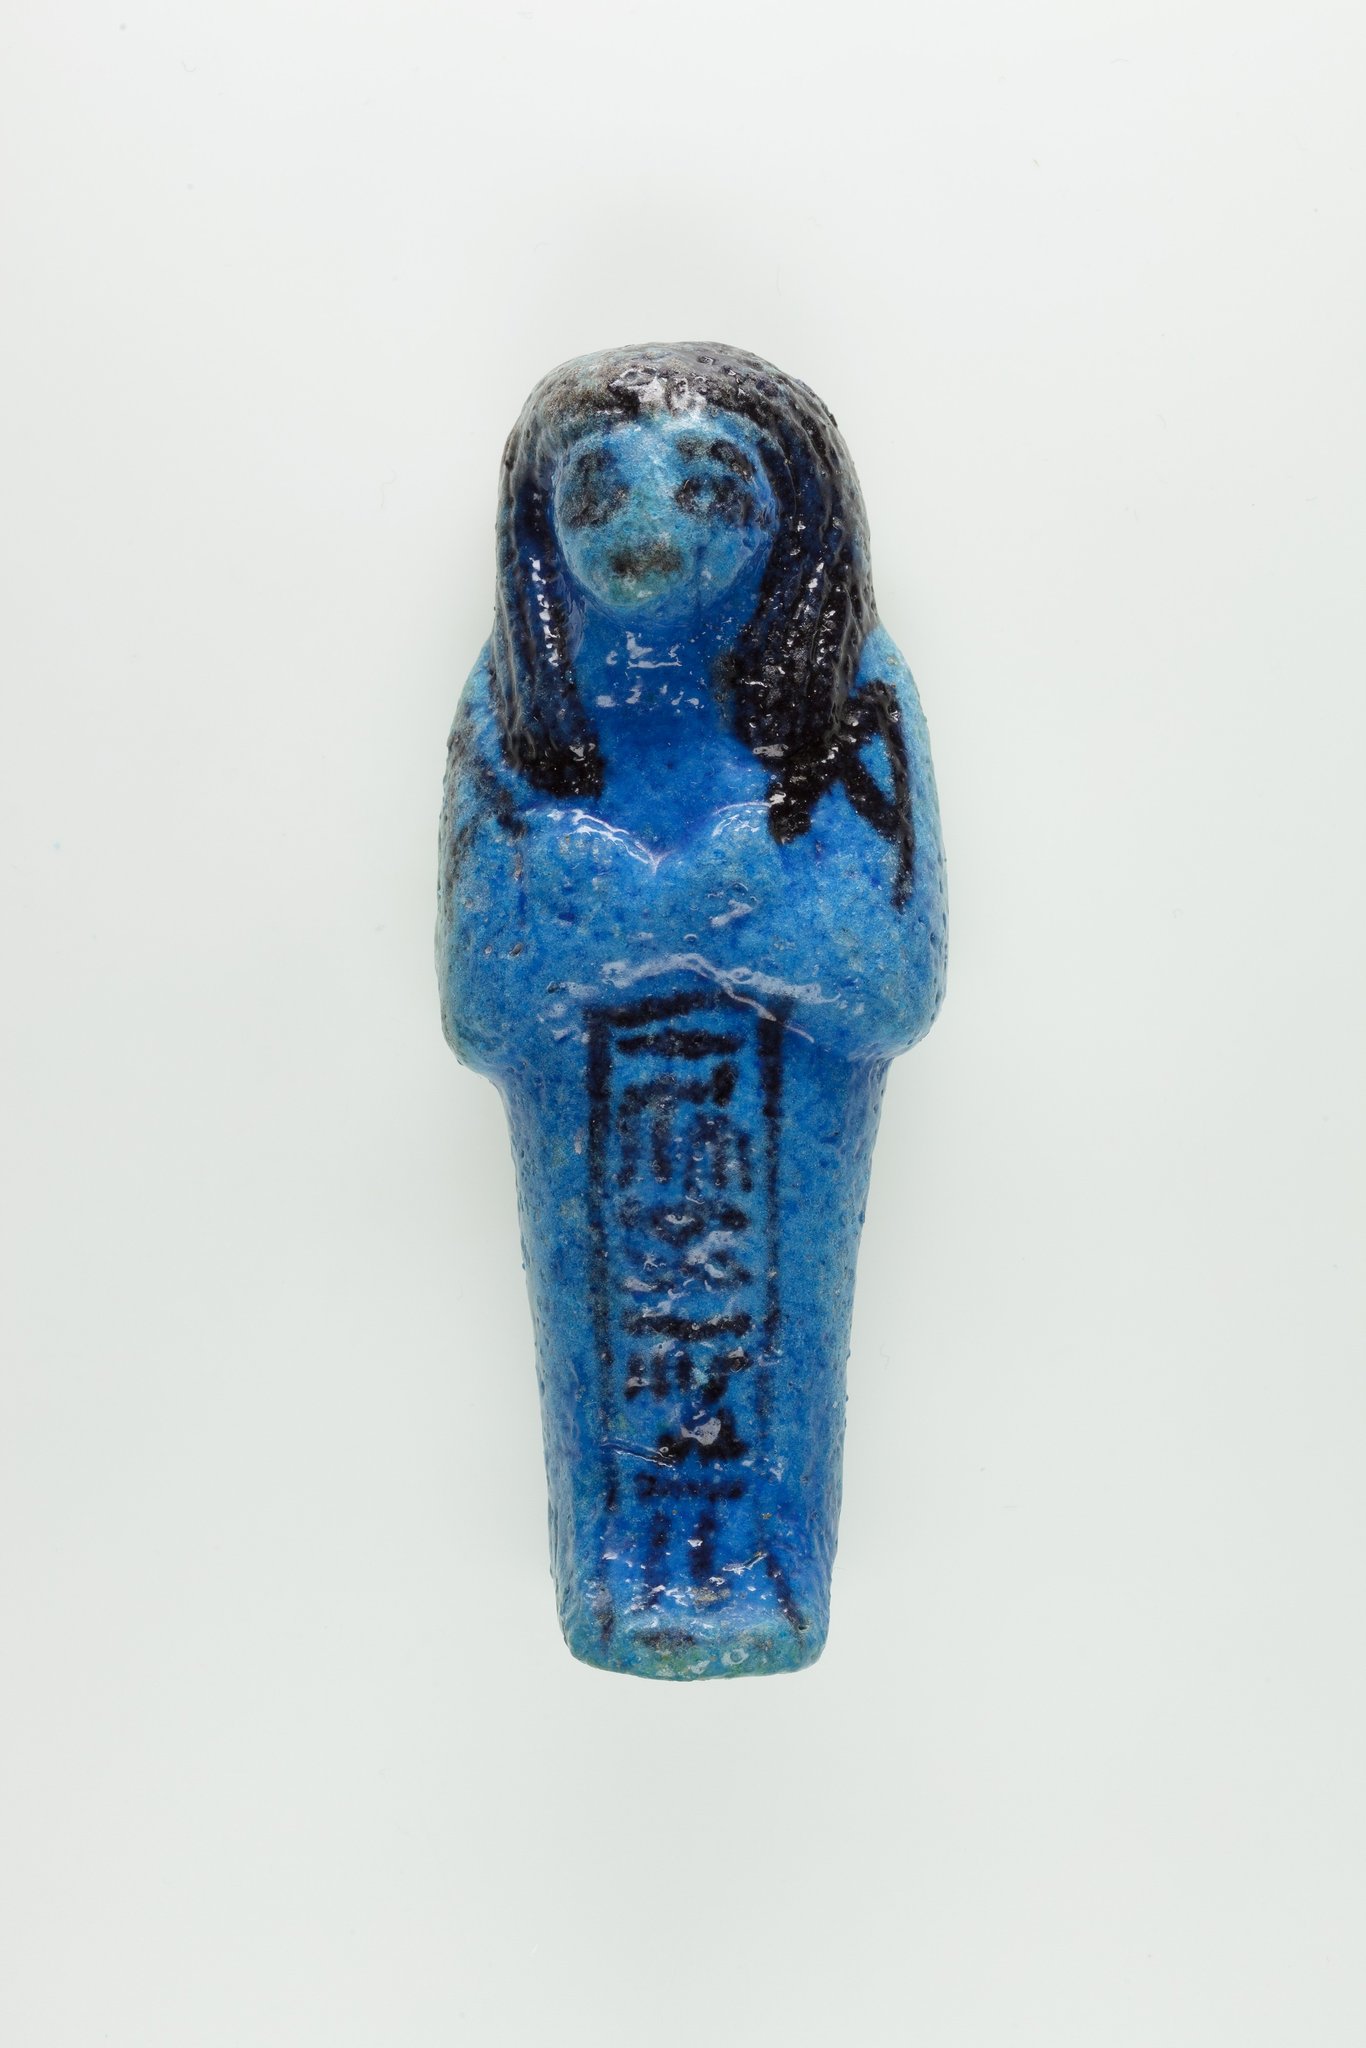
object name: shabti, worker, nauny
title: Worker Shabti of Nauny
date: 1050 BCE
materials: faience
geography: egypt